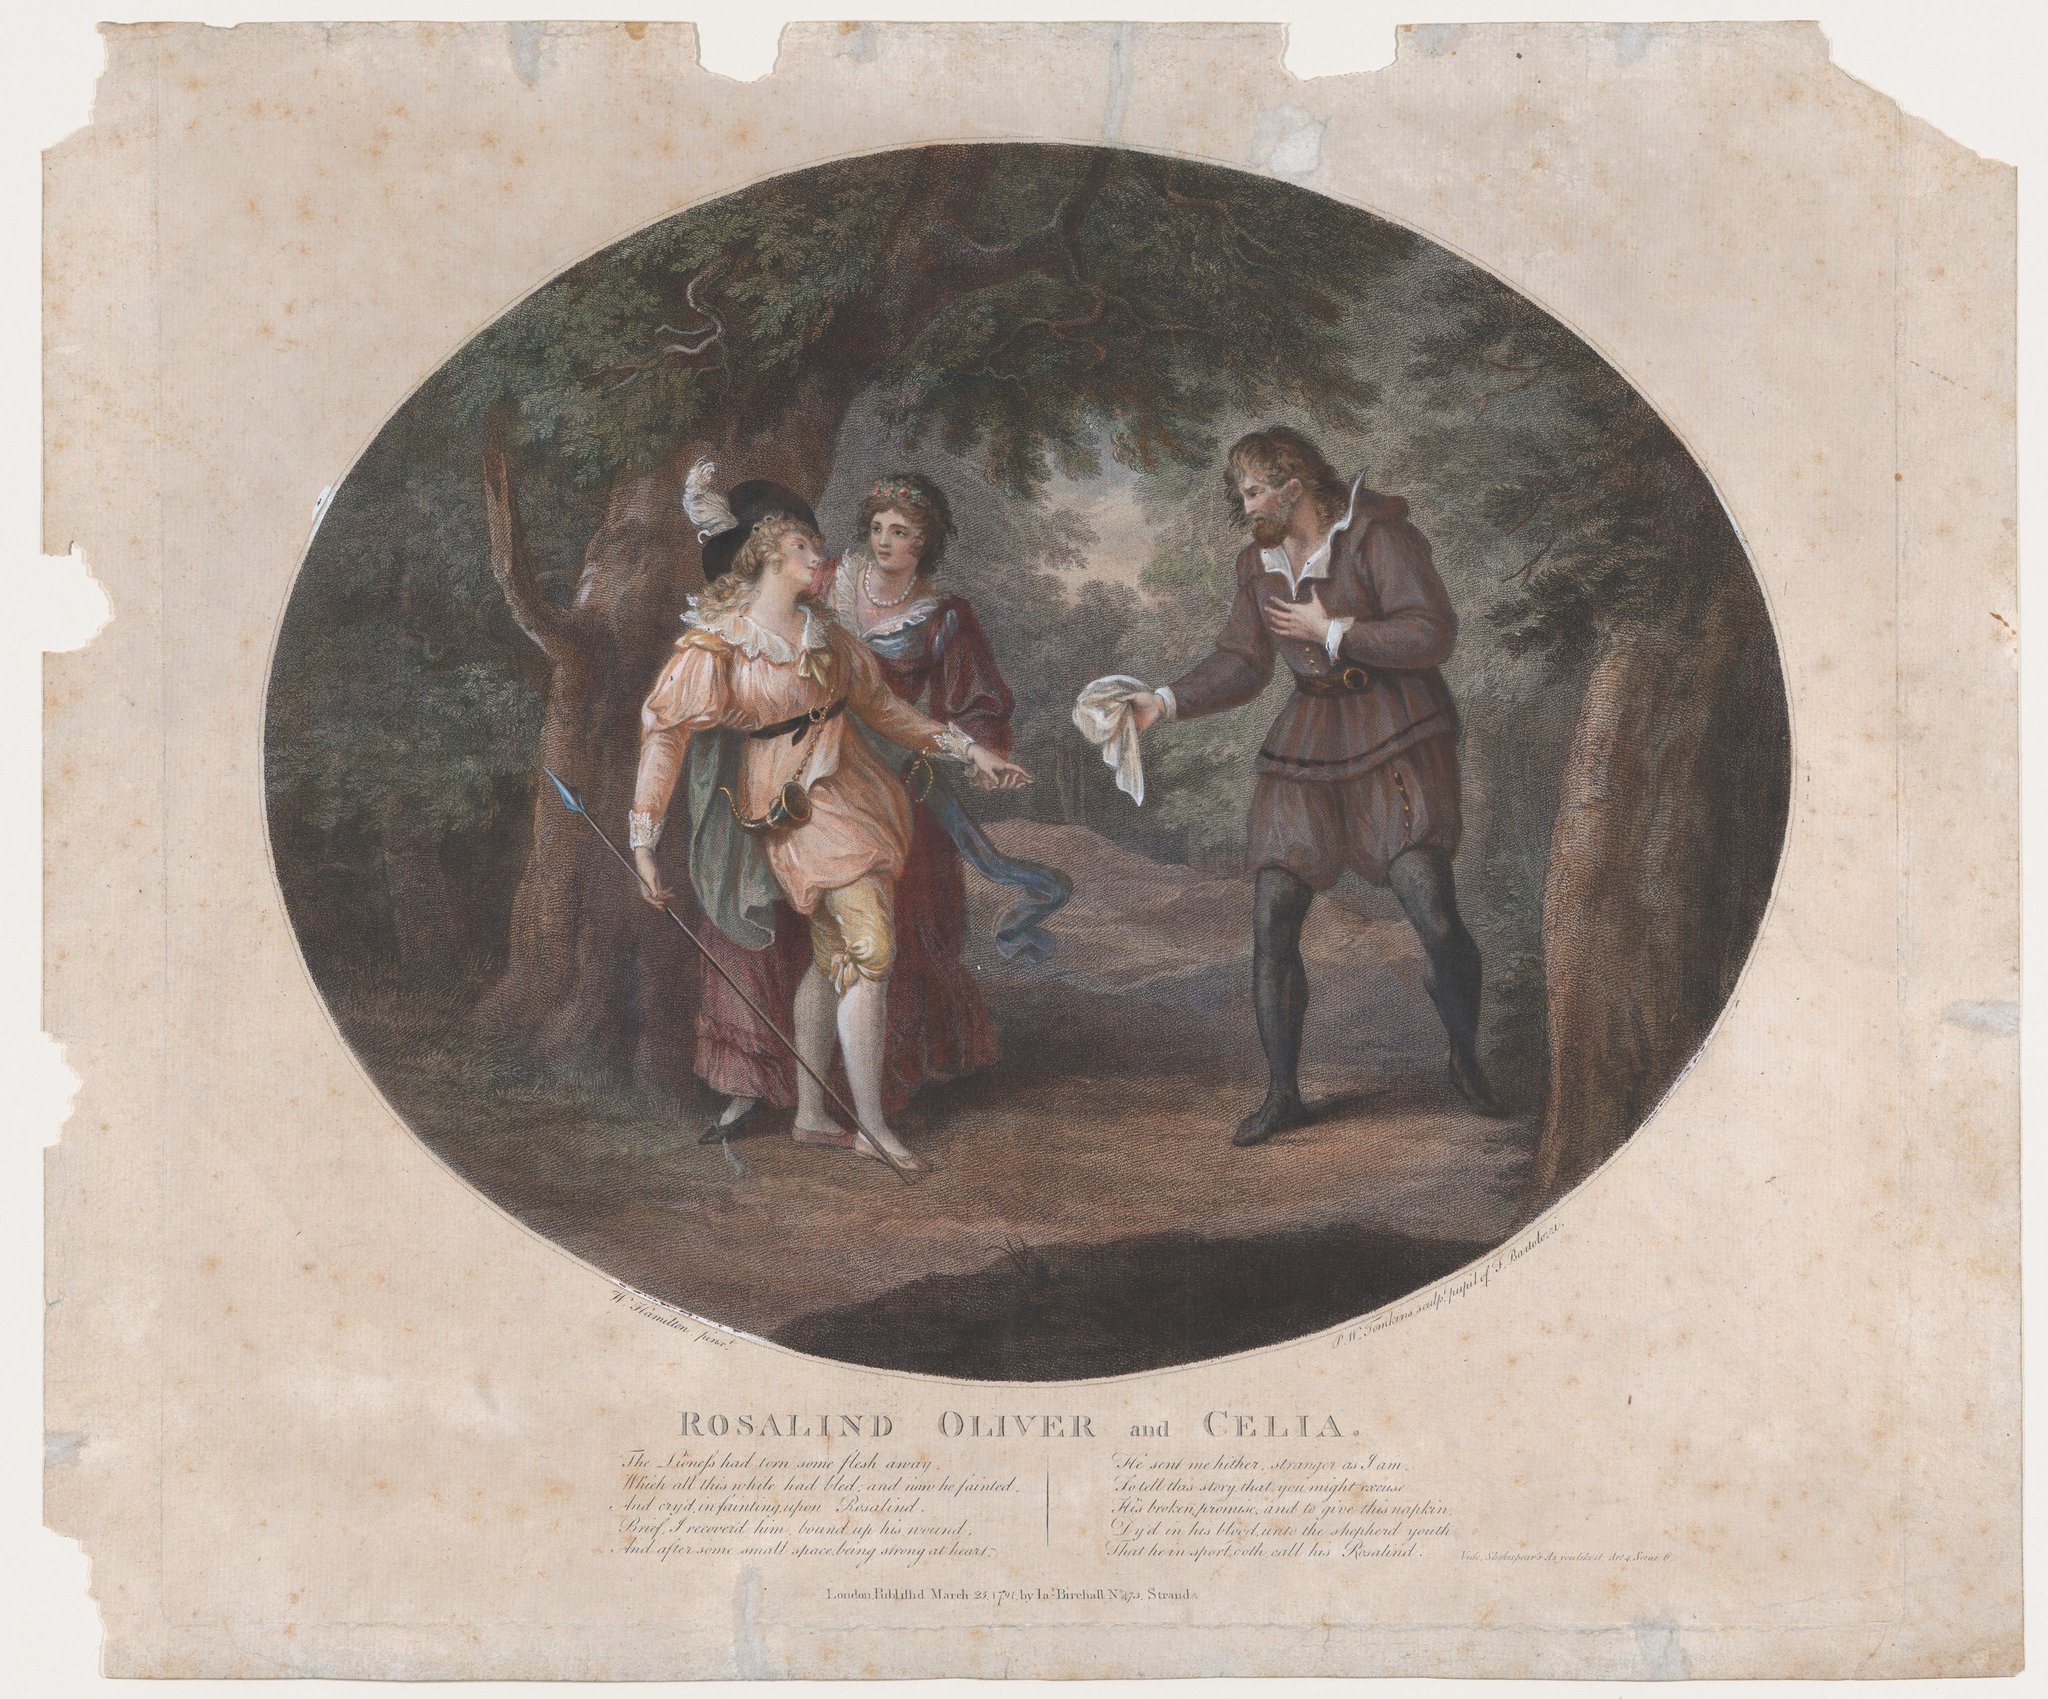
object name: print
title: Rosalind, Oliver and Celia (Shakespeare, As You Like It, Act 4, Scene 6)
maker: peltro william tomkins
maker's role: engraver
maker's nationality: british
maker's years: 1759-1840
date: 1791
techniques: engraving, etching, hand coloring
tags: shakespeare,men,women